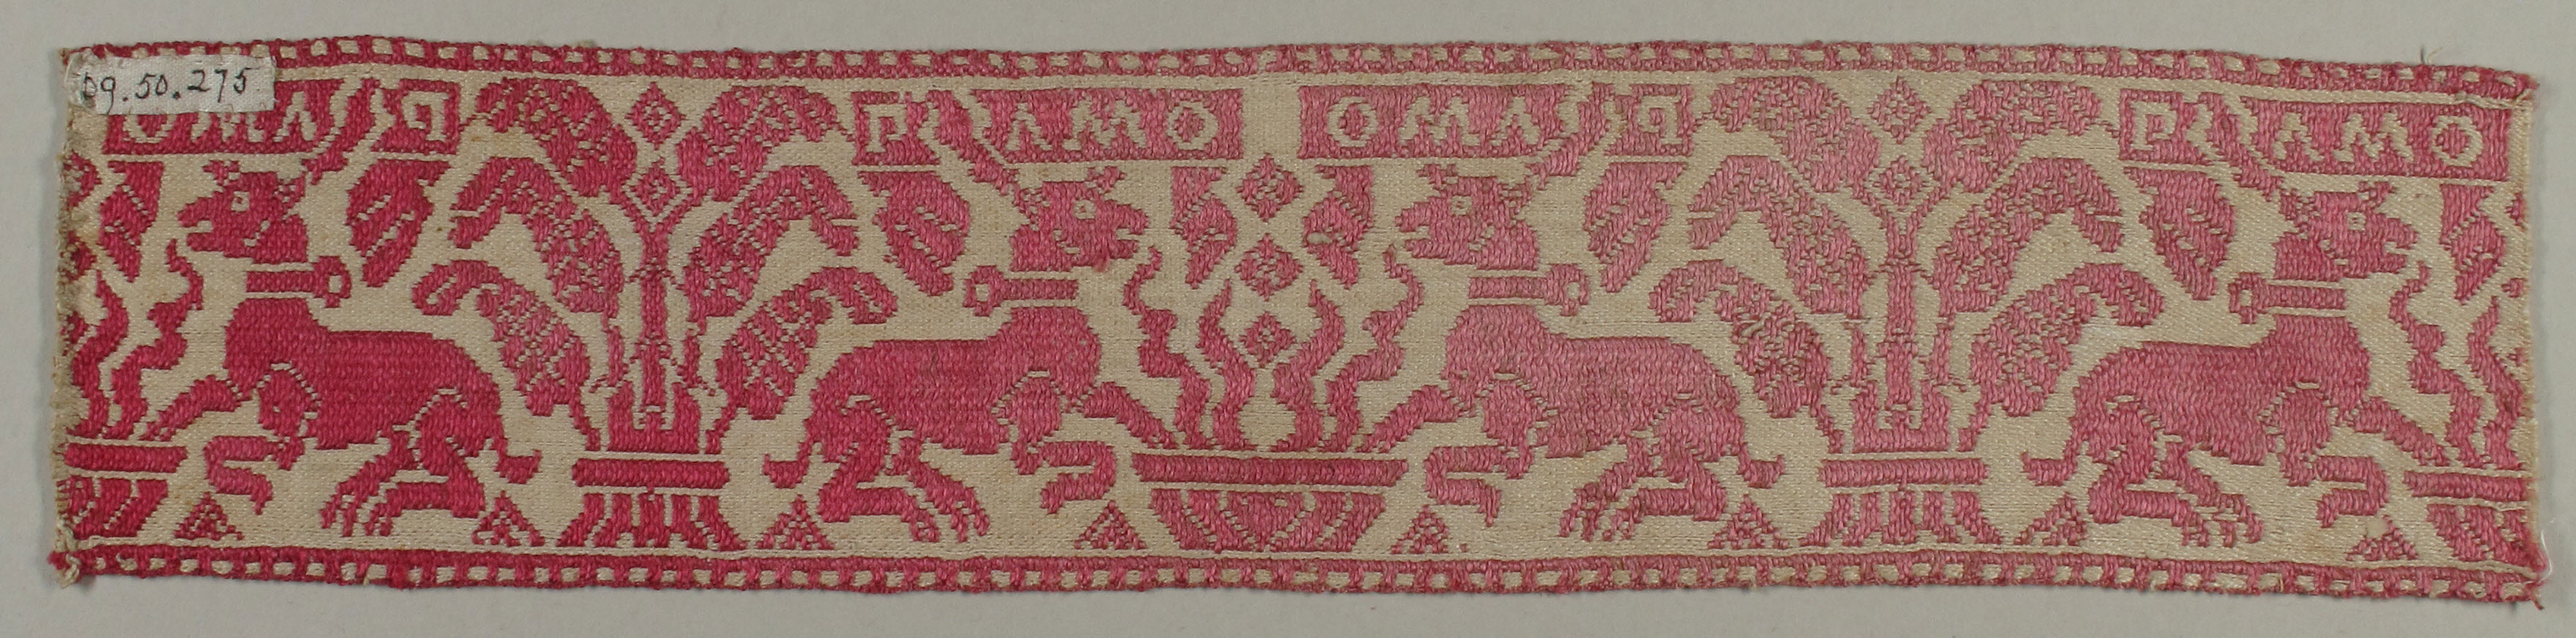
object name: band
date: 1501-1600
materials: cotton, silk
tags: animals